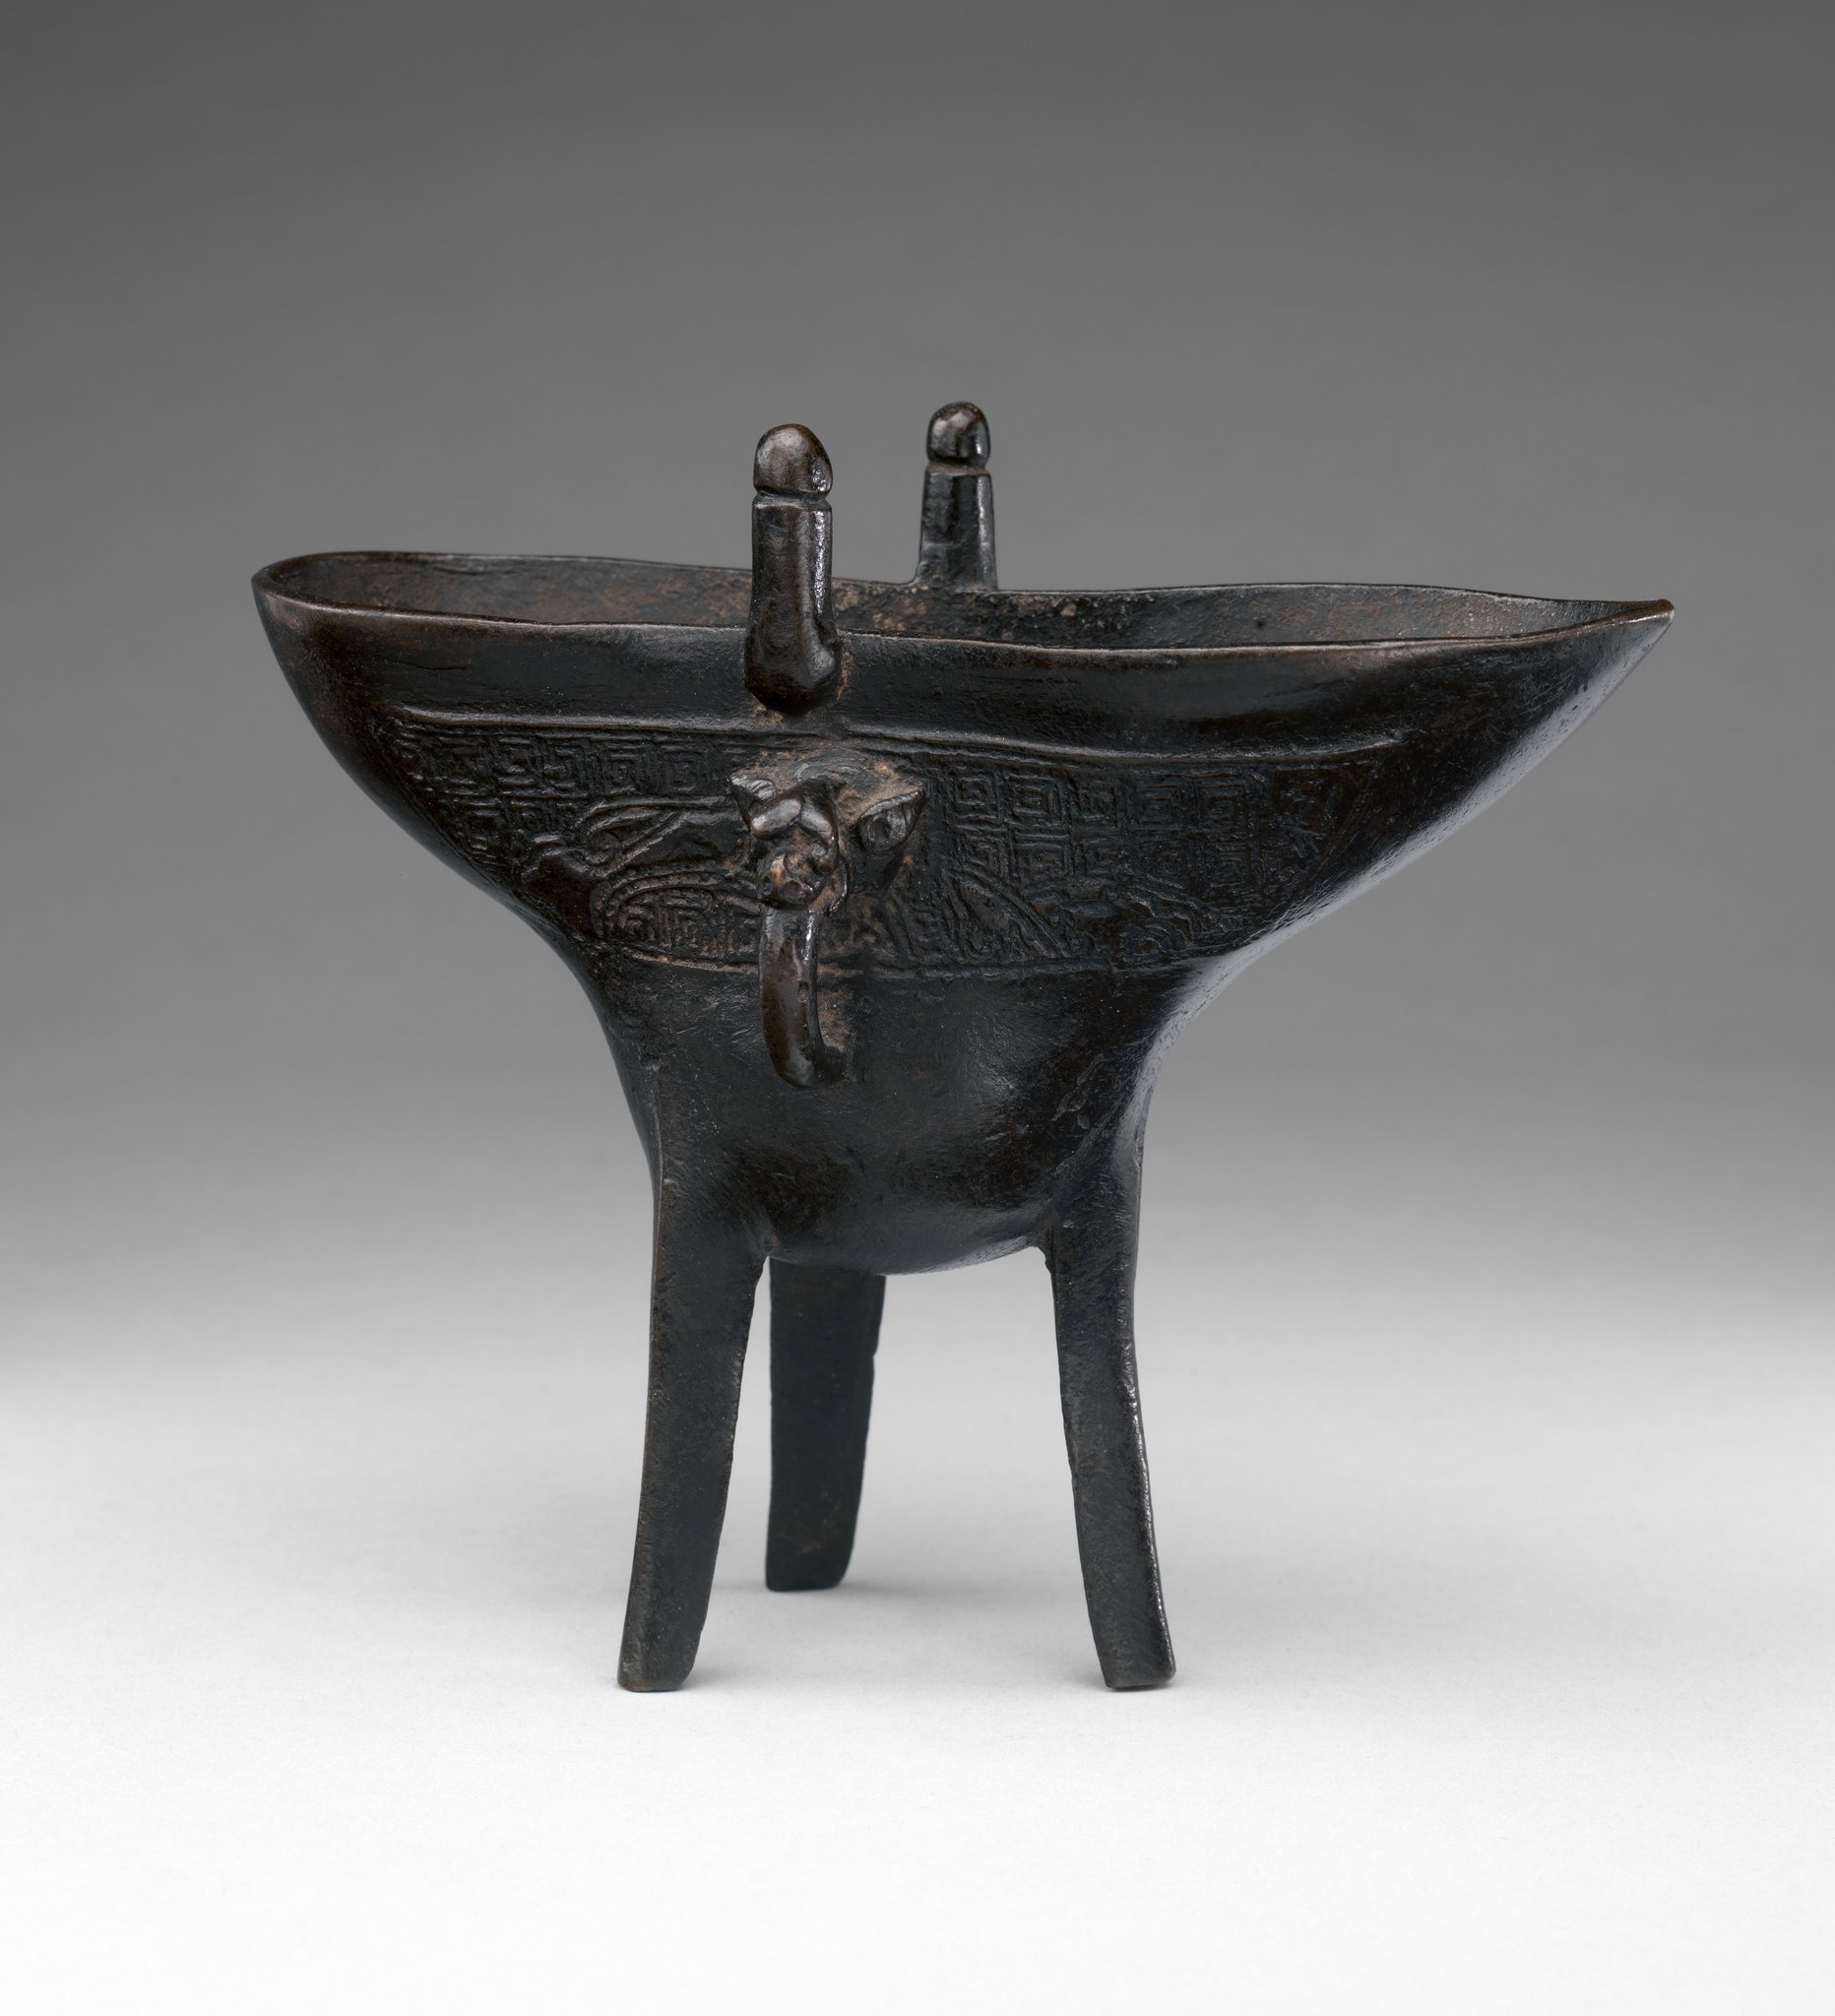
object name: wine cup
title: Ritual wine cup (jue)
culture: chinese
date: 1520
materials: copper alloy